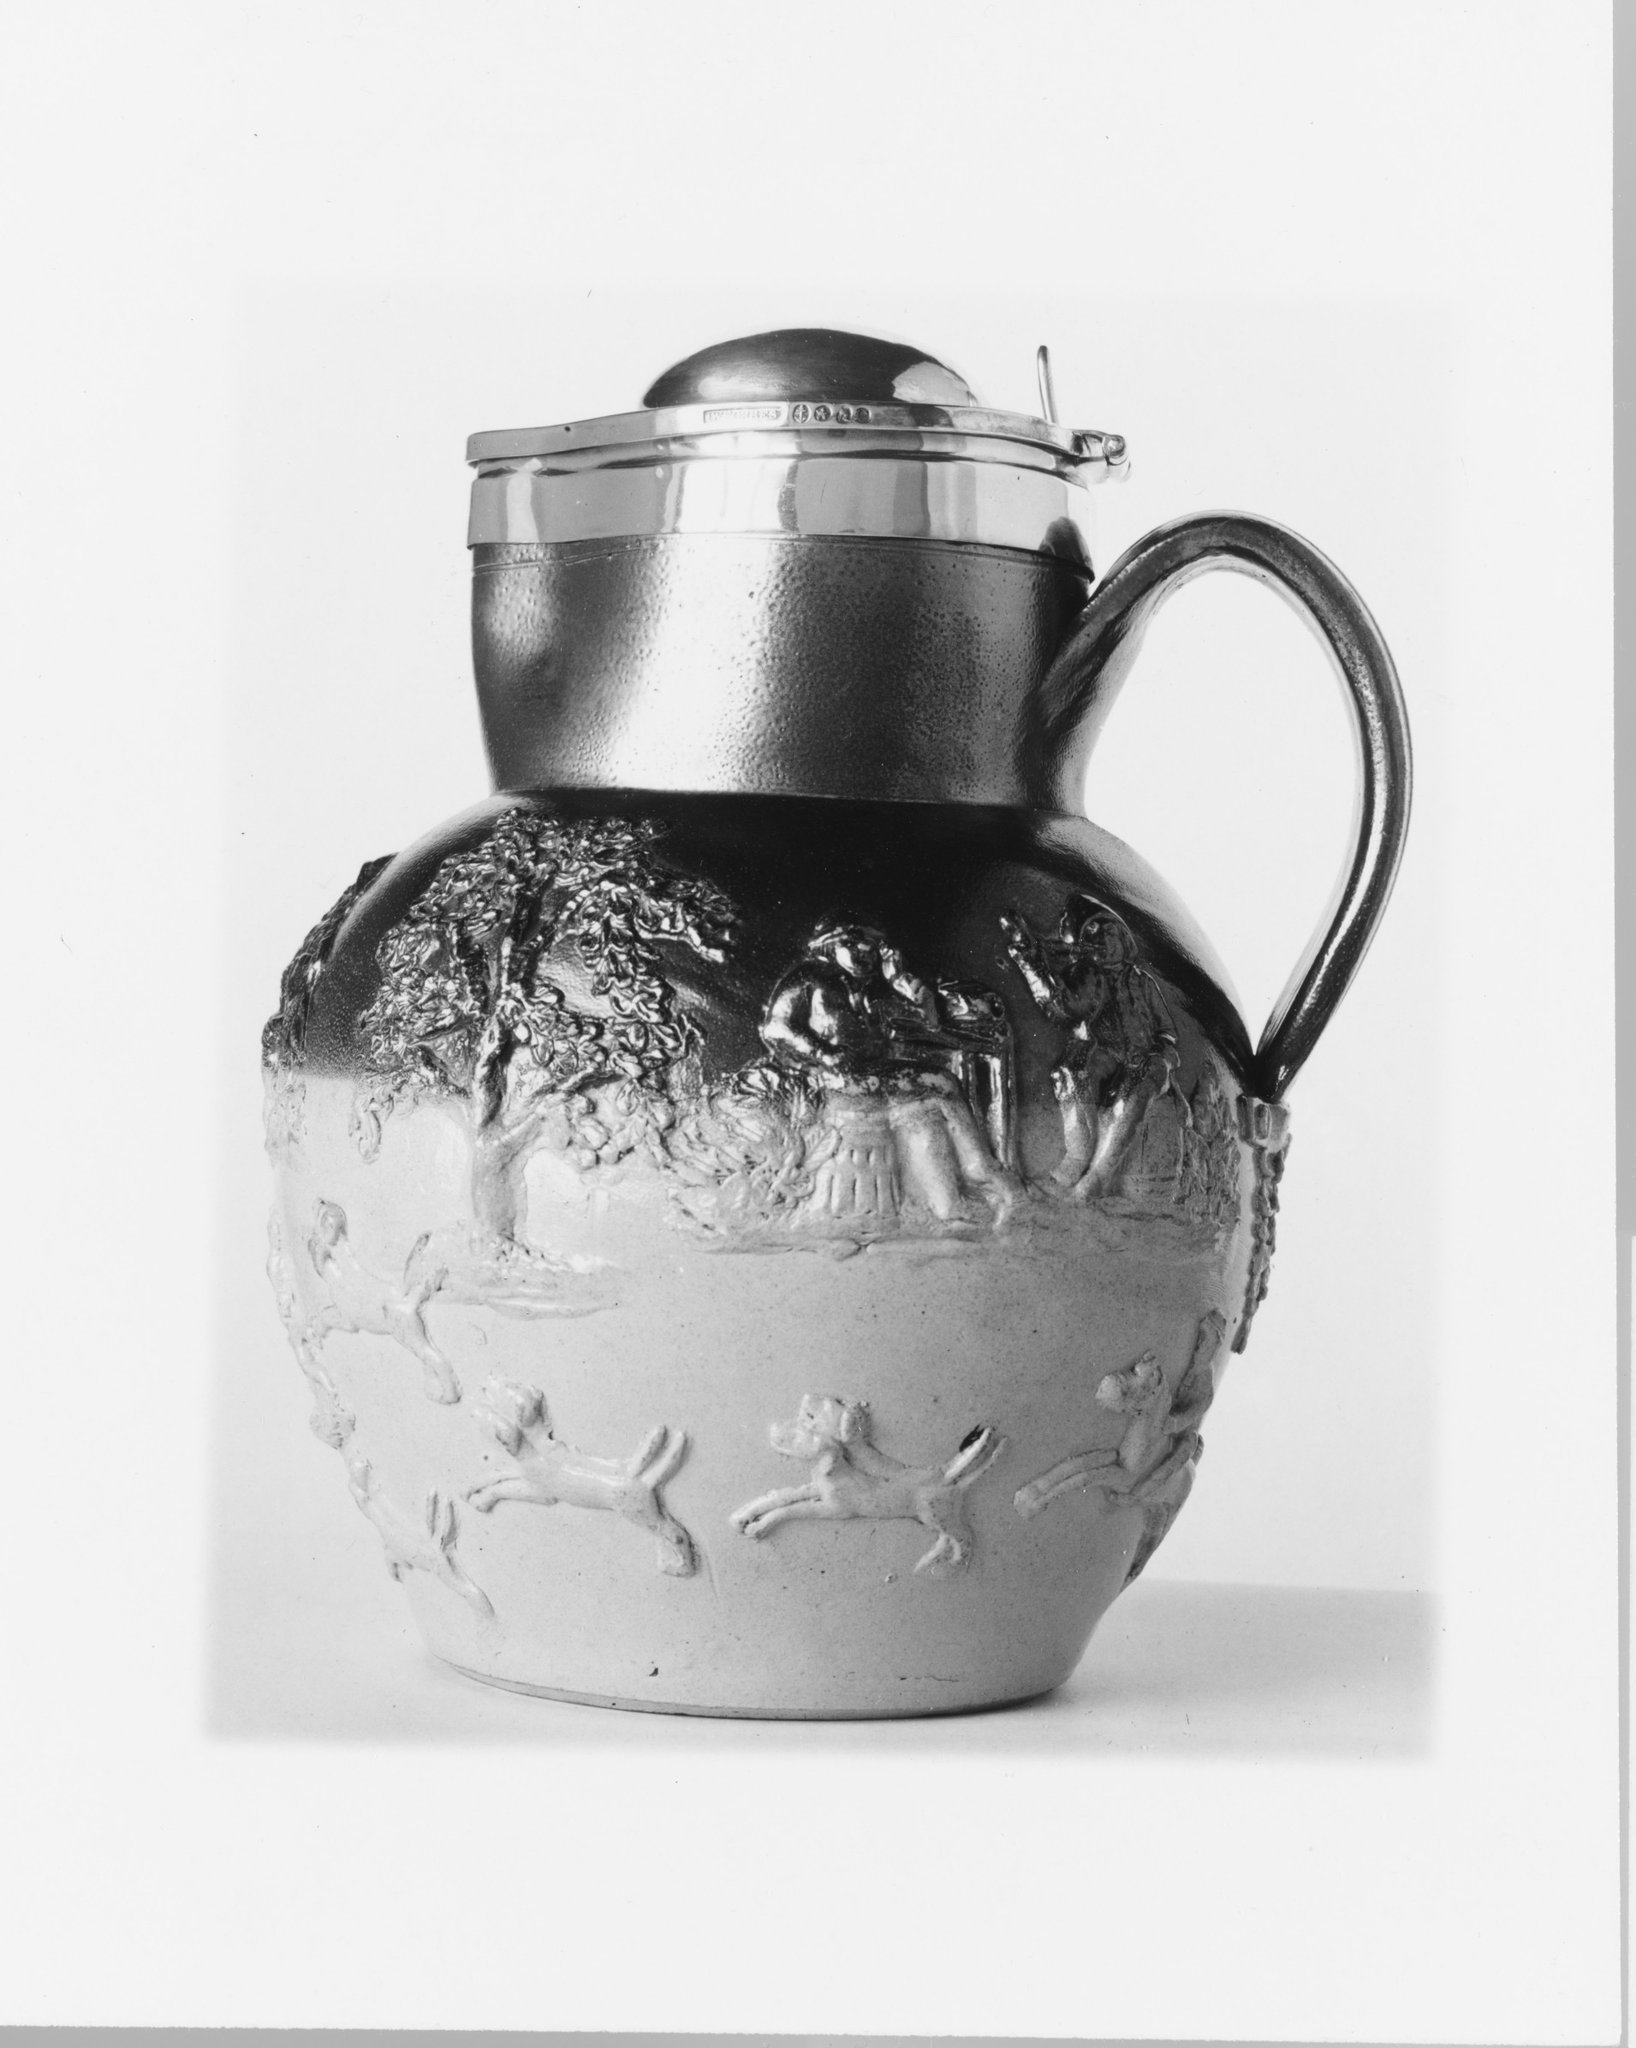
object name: jug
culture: american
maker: john w. forbes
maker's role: maker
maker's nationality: american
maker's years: 1781-1864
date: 1810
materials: ceramic, silver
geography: united states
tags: men,hunting,dogs